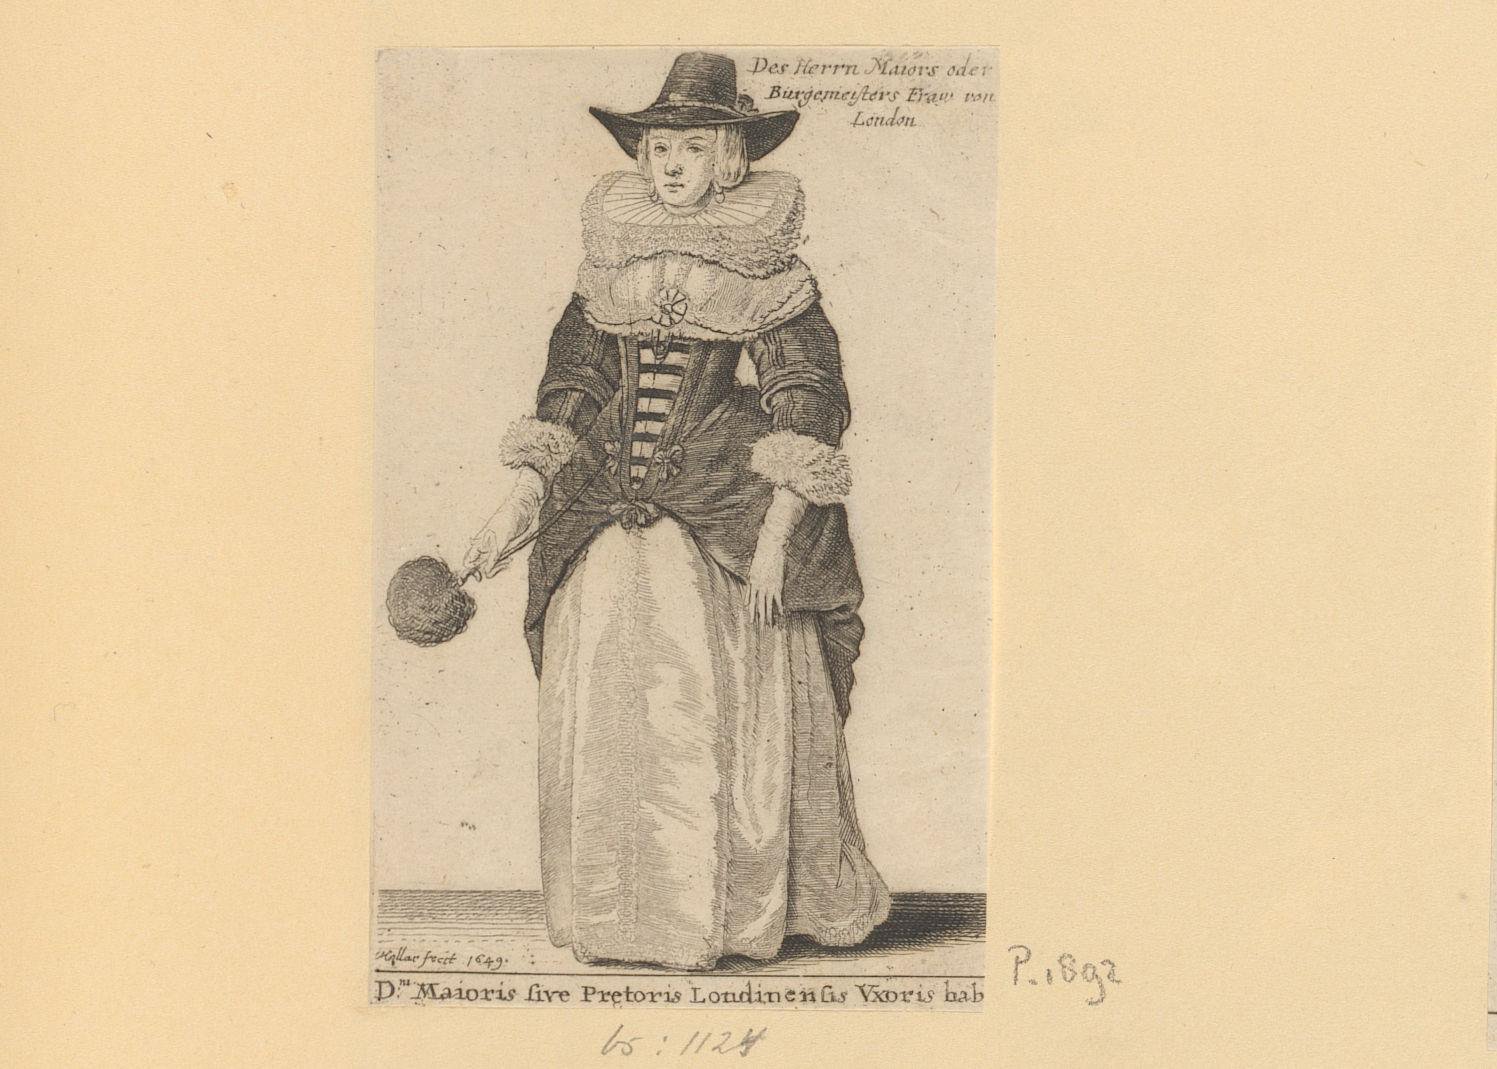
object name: print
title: Vrouwelijke klederdrachten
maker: wenceslaus hollar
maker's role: draughtsman, print maker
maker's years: 1607-1677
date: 1649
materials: paper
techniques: etching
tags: adult woman, folk costume, regional costume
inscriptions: date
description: Prent maakt mogelijk deel uit van een serie van 200 prenten. Deze serie is onder de titel 'A Collection of two hundred original etchings' voor het eerst uitgegeven door J.M. Greery in 1816.